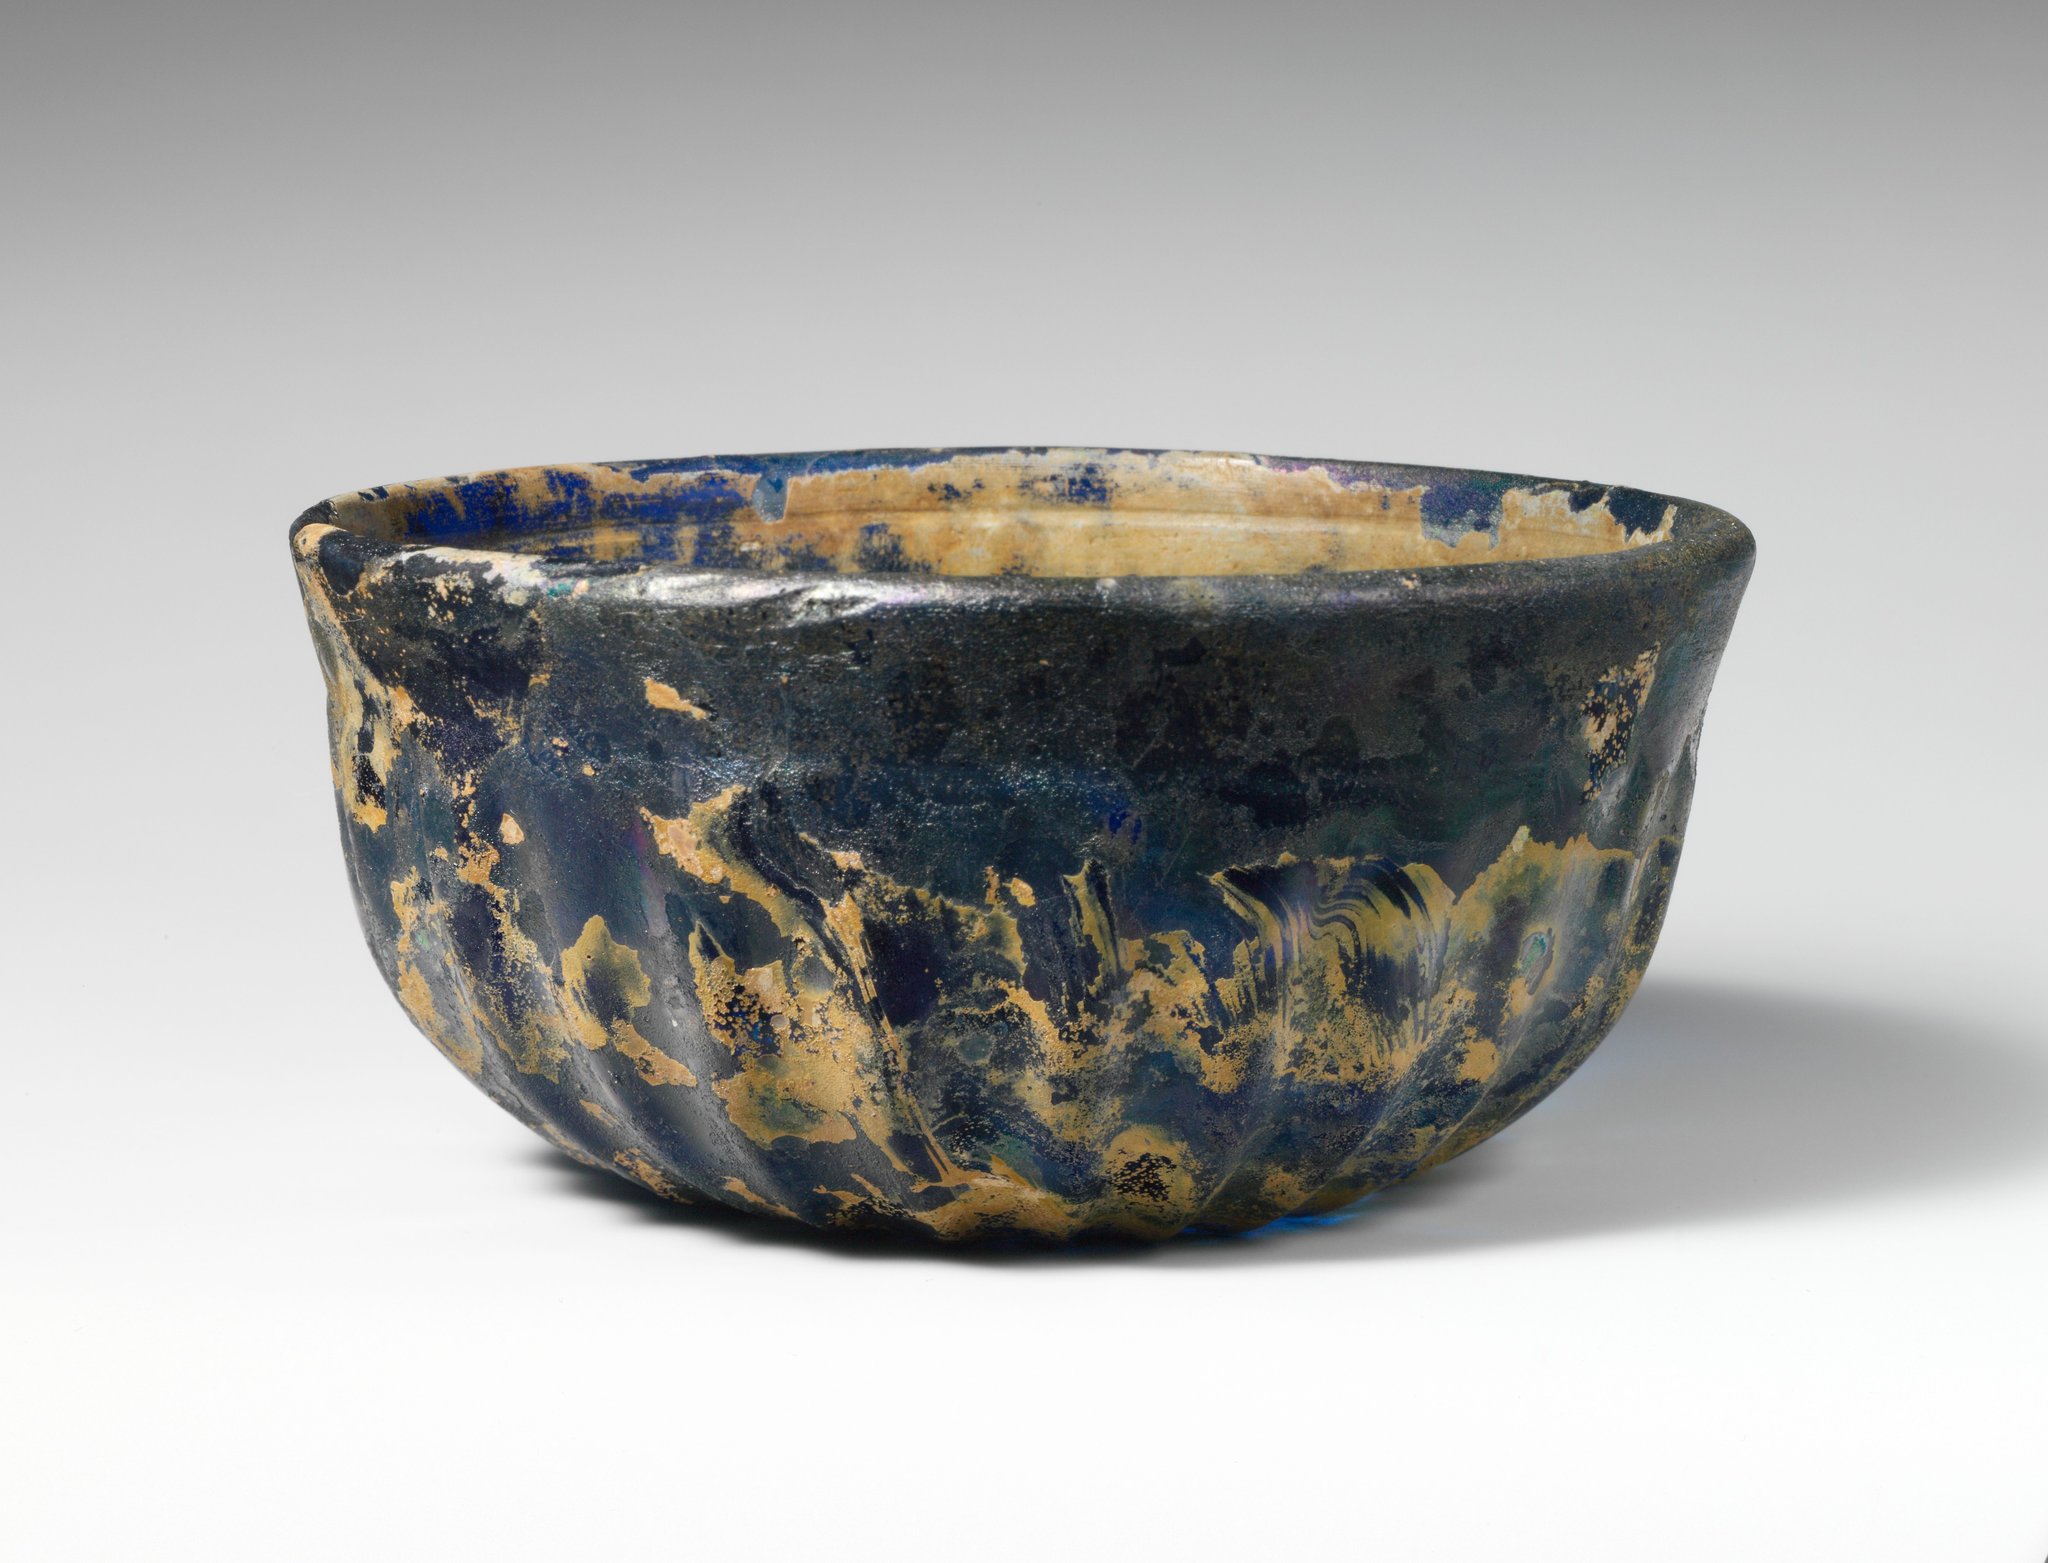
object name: bowl, ribbed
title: Glass ribbed bowl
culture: roman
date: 34 BCE-33 CE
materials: glass